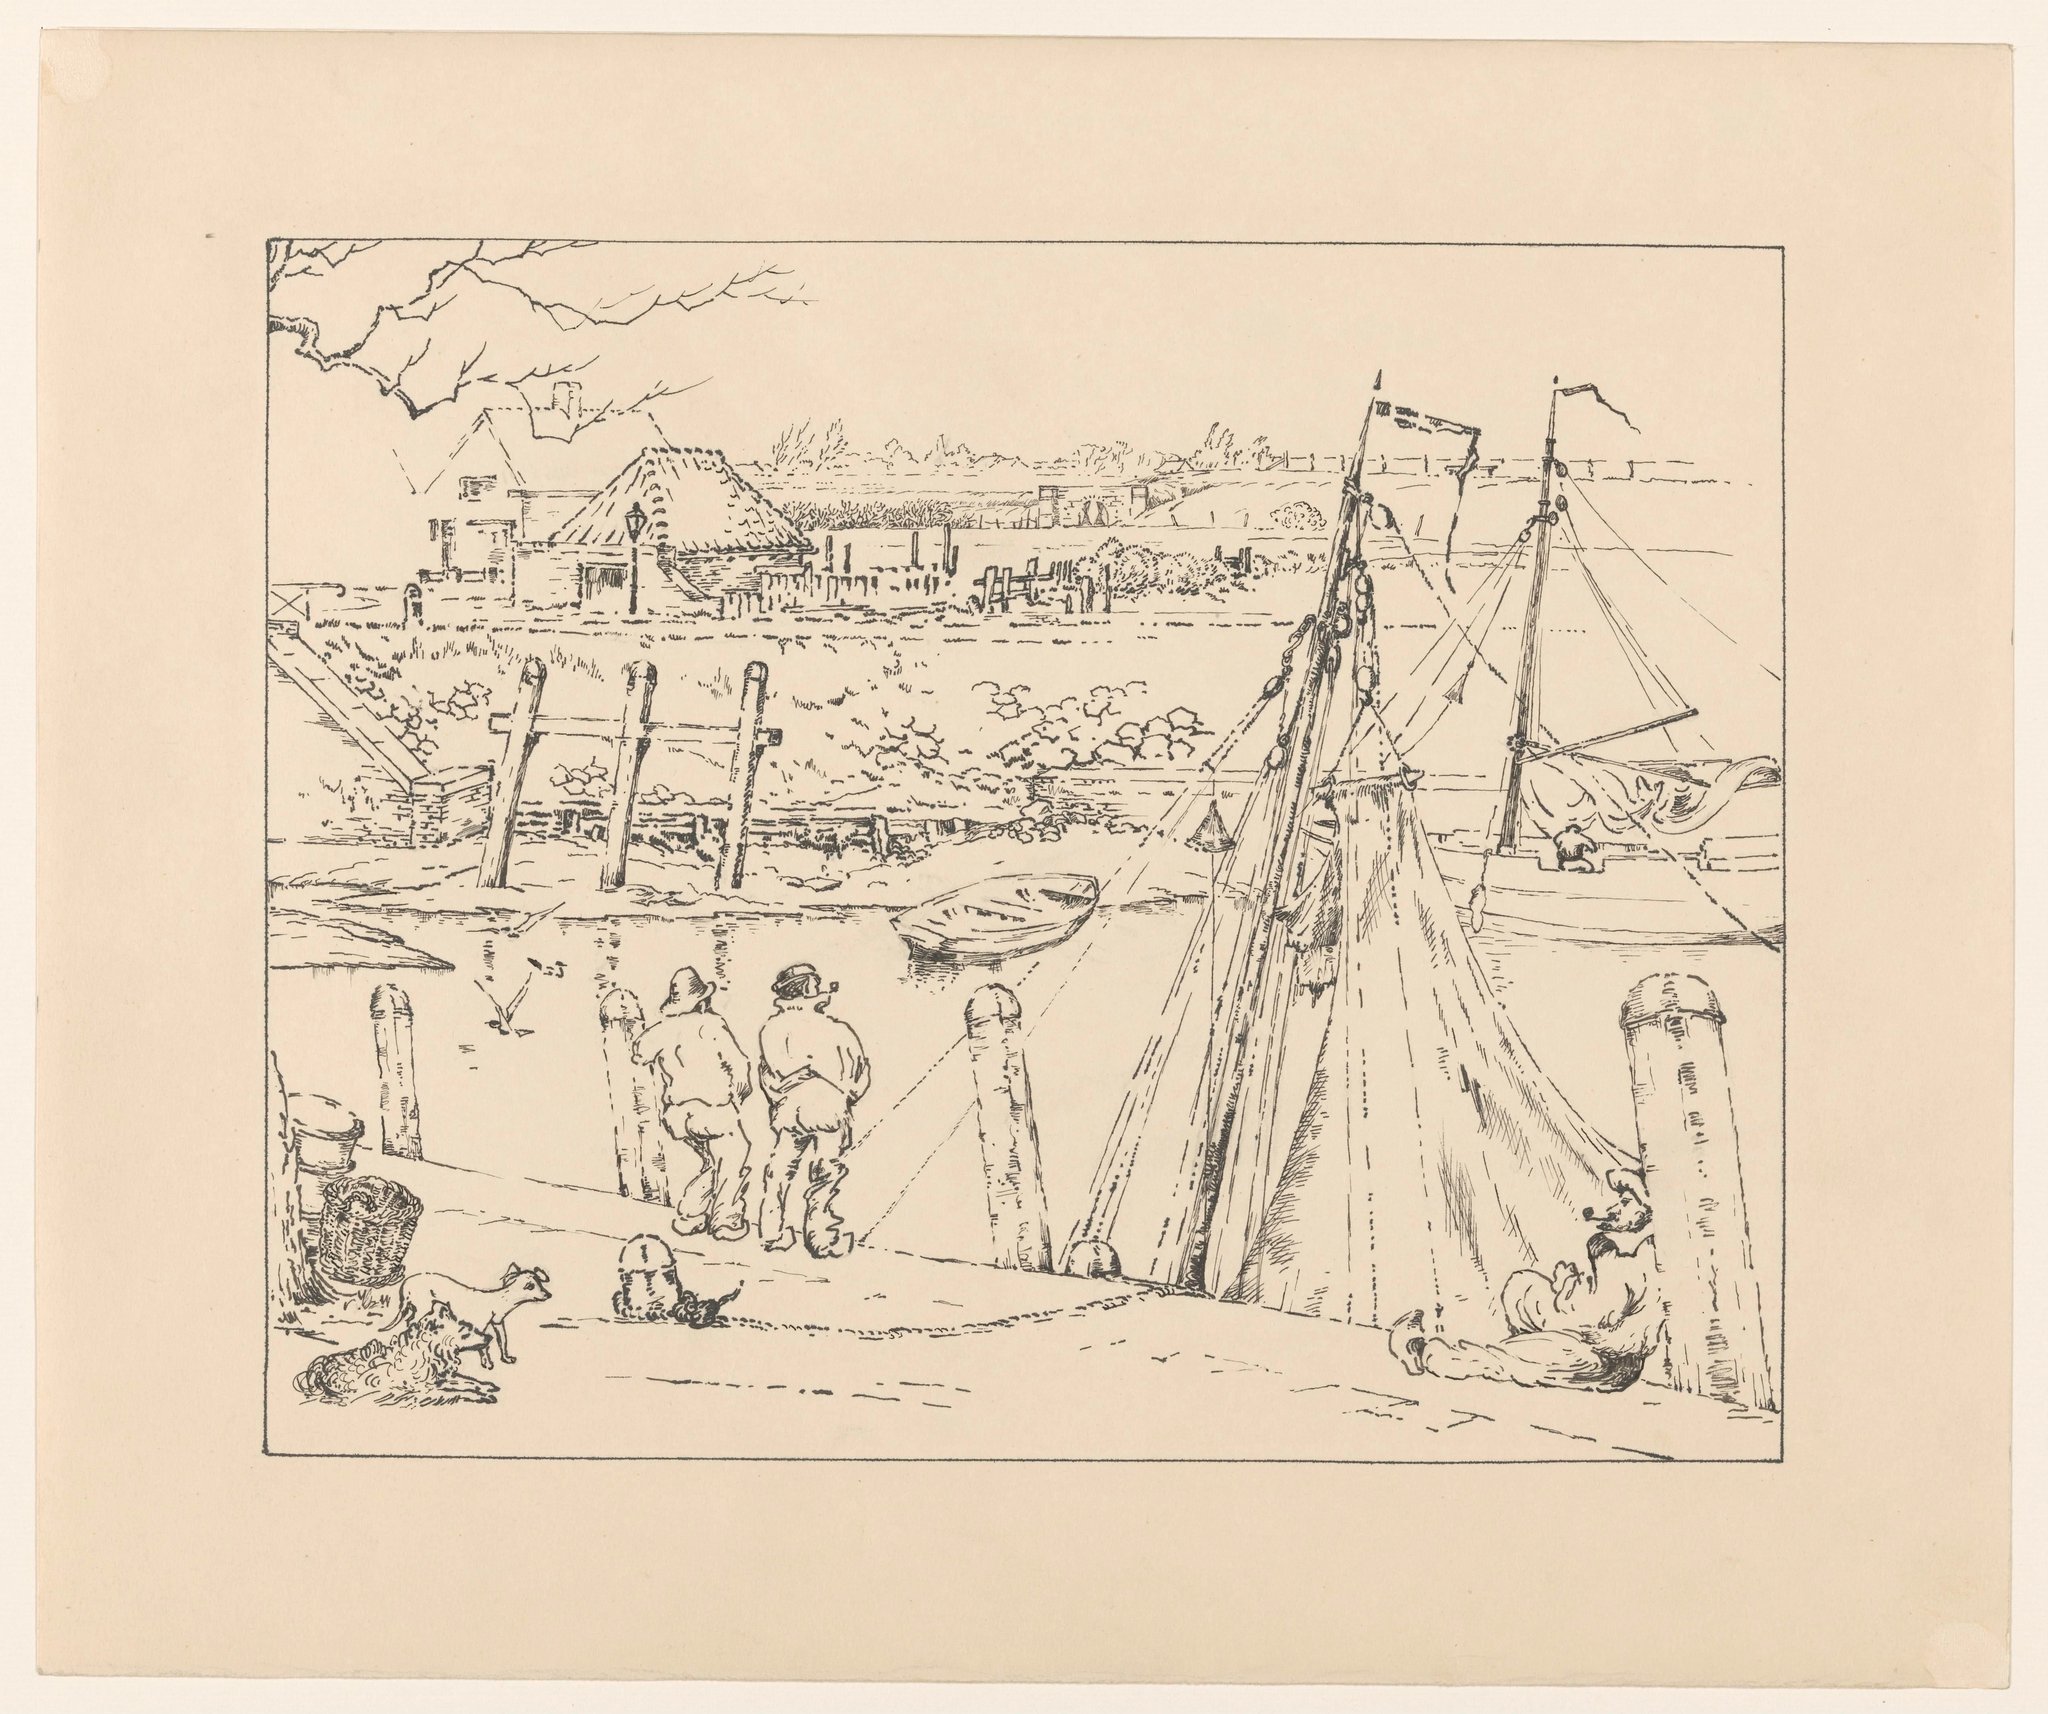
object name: drawing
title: De haven te Veere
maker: johannes frederik engelbert ten klooster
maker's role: draughtsman, print maker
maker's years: 1873-1940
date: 1883-1940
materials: ink, paper, pencil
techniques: pen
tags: harbour